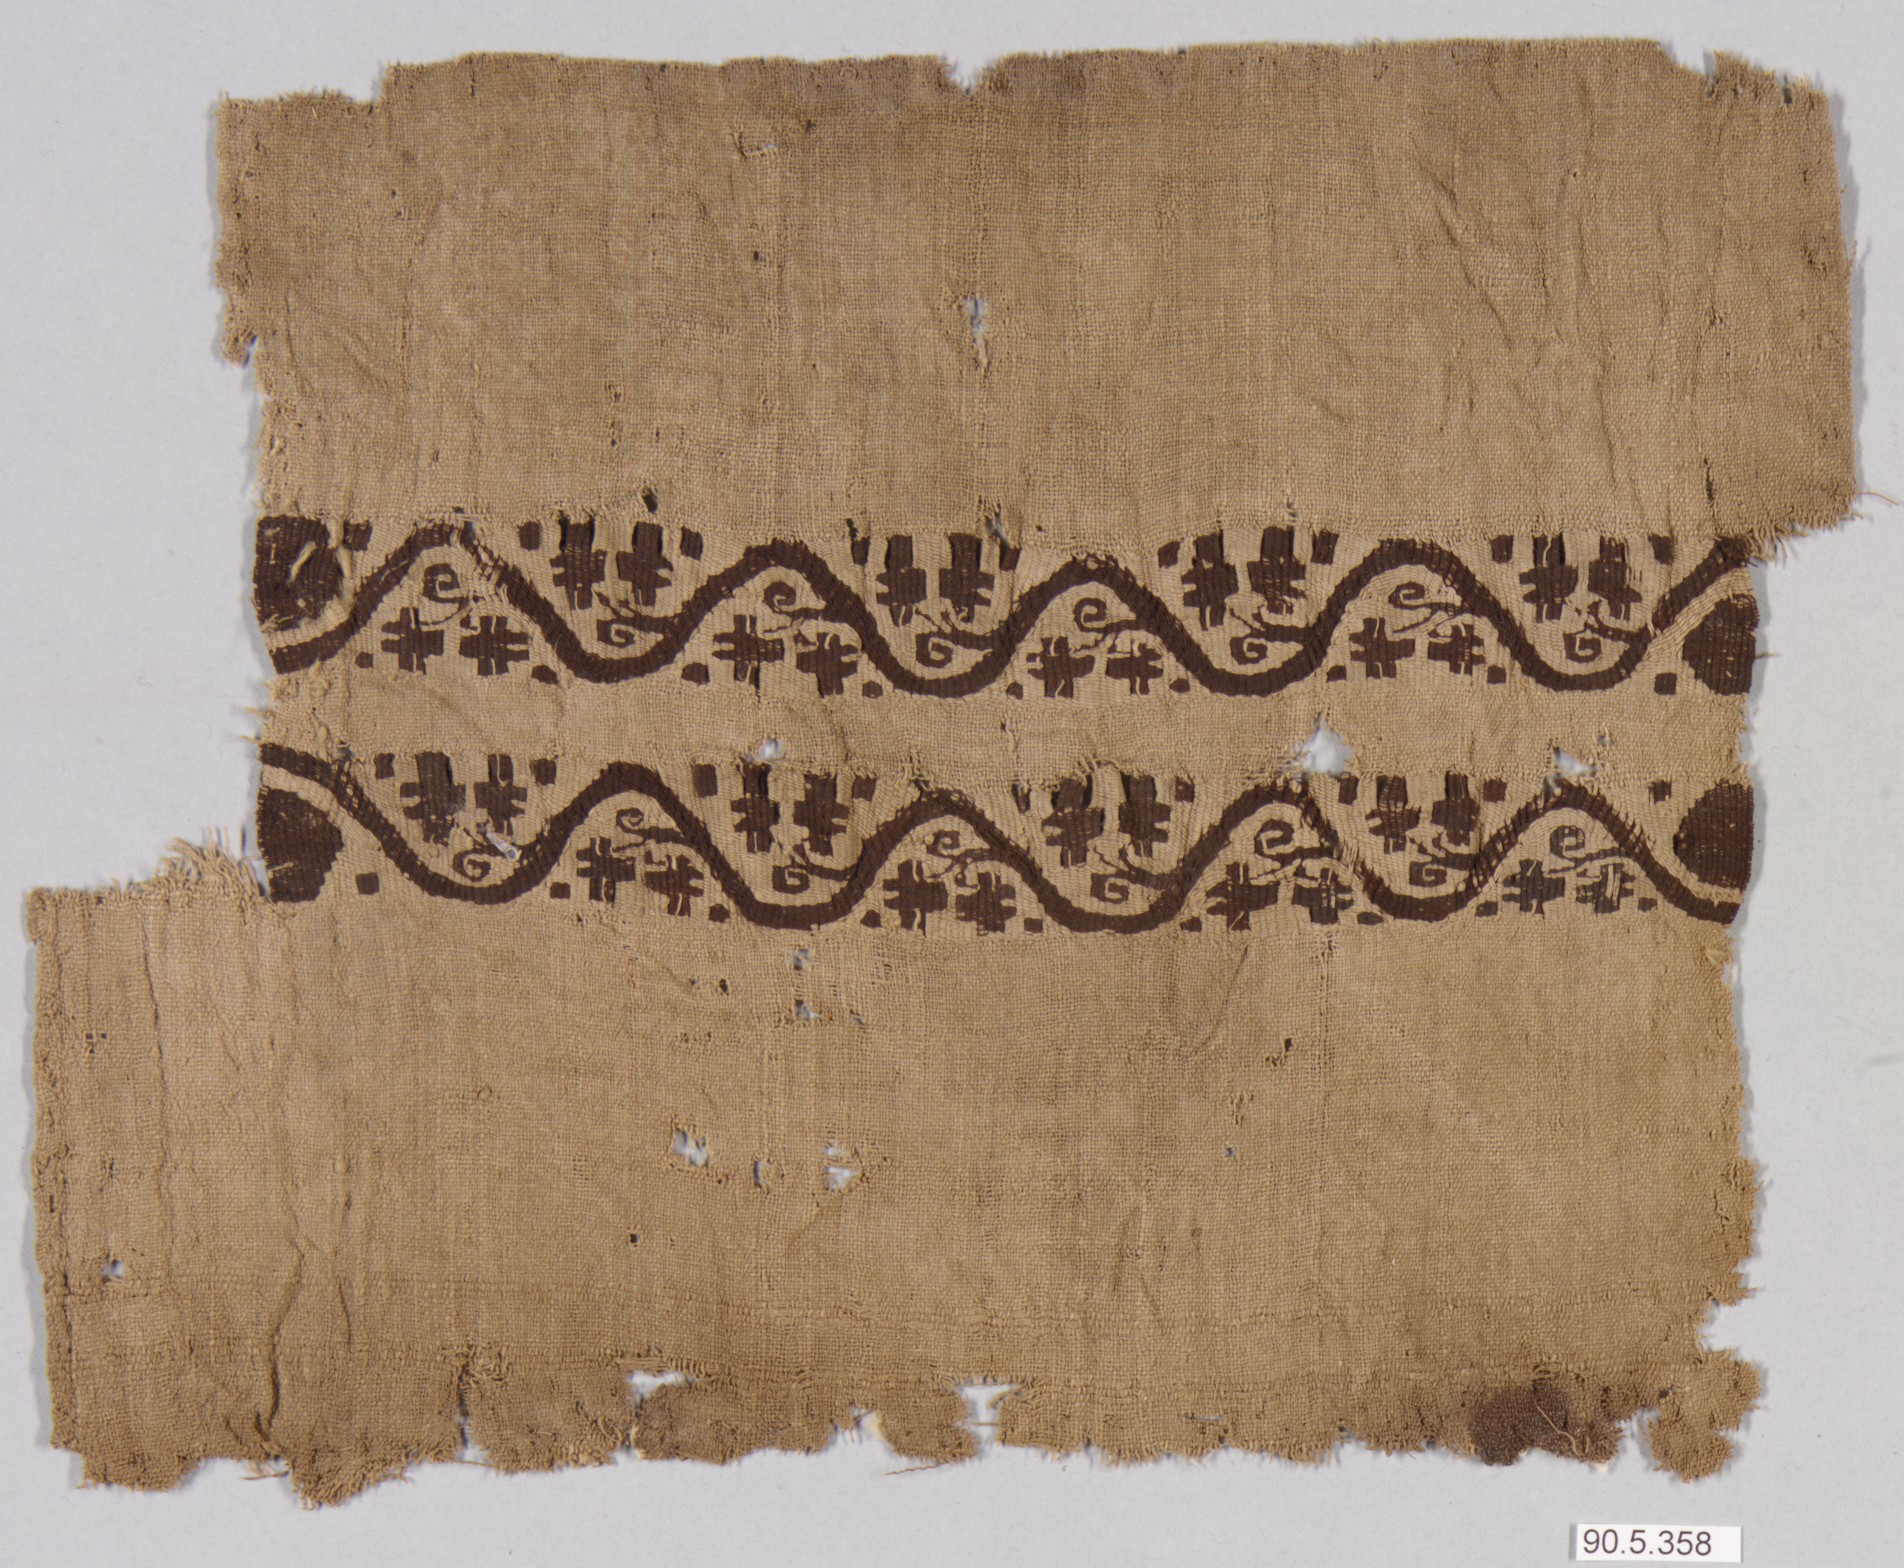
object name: textile fragment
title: Fragment of a Tunic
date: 201-400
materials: linen, wool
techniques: weave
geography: egypt